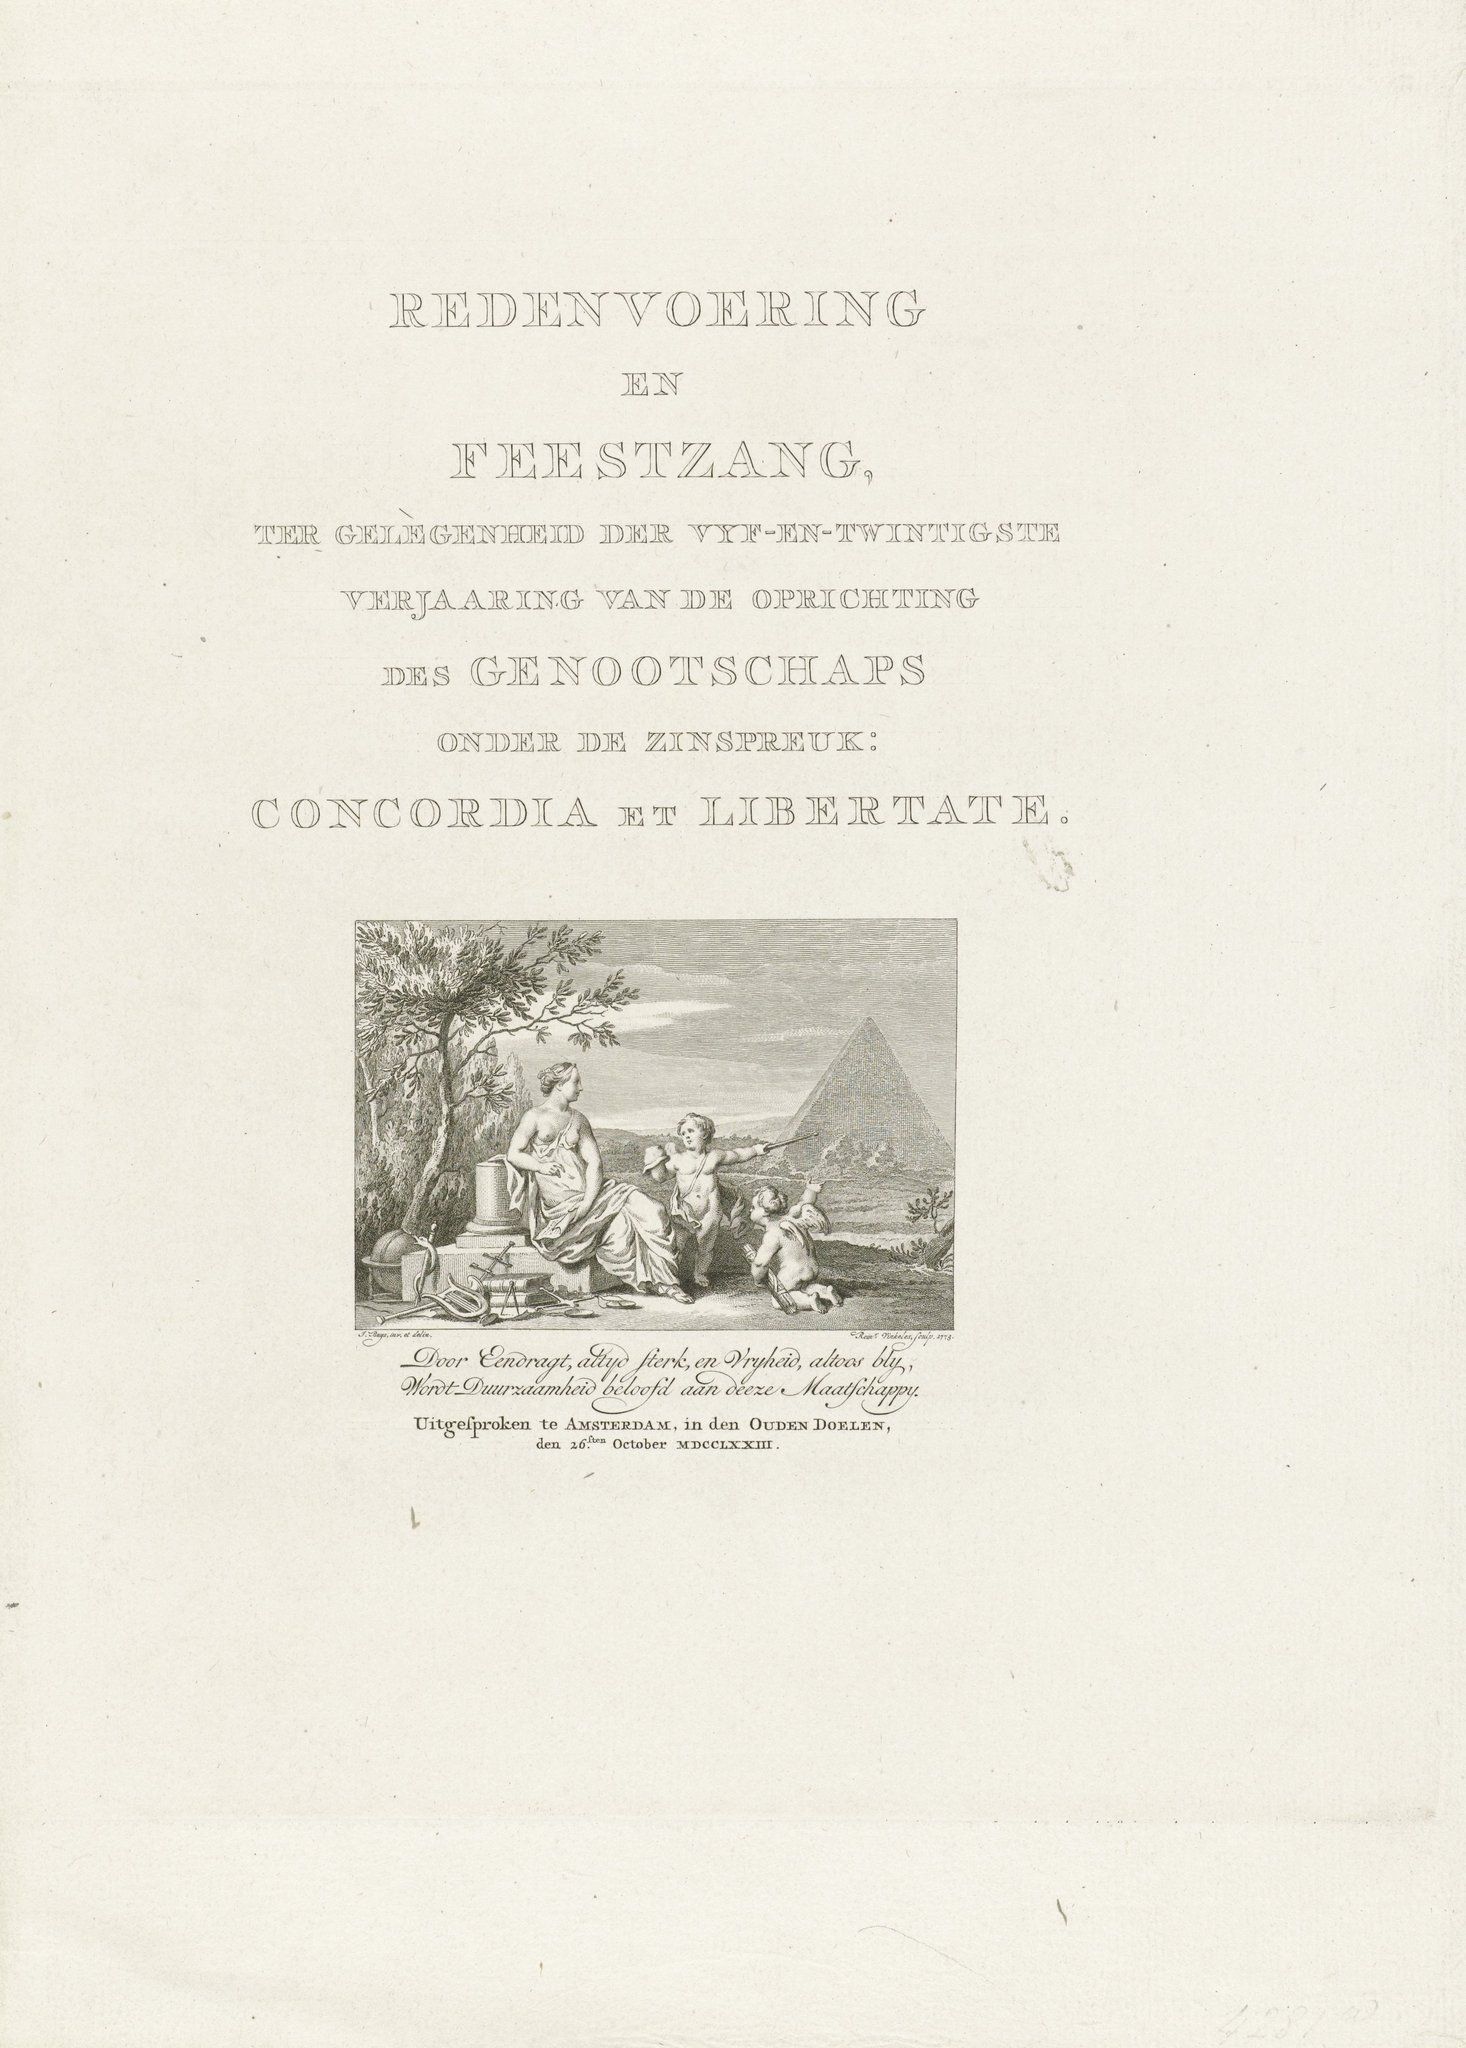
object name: titelblad, titelpagina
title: Titelpagina voor: Redenvoering en feestzang, ter gelegenheid der vyf-en-twintigste verjaaring van de oprichting des genootschaps onder de zinspreuk: Concordia et libertate, 1773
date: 1773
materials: paper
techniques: engraving, etching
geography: northern netherlands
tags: amsterdam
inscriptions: collector's mark: Lugt 2228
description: Titelblad voor de uitgave van de redevoering en feestzang ter gelegenheid van het 25-jarig jubileum van het Genootschap Concordia et Libertate in 1773. Allegorisch vignet op de redevoering uitgesproken op 26 oktober 1773 in de Oude Doelen te Amsterdam. Landschap met piramide, op de voorgrond een zittende vrouw leunend op een afgebroken zuil met attributen van de kunsten en wetenschappen, hierbij ook twee engeltjes en een tweeregelig onderschrift.